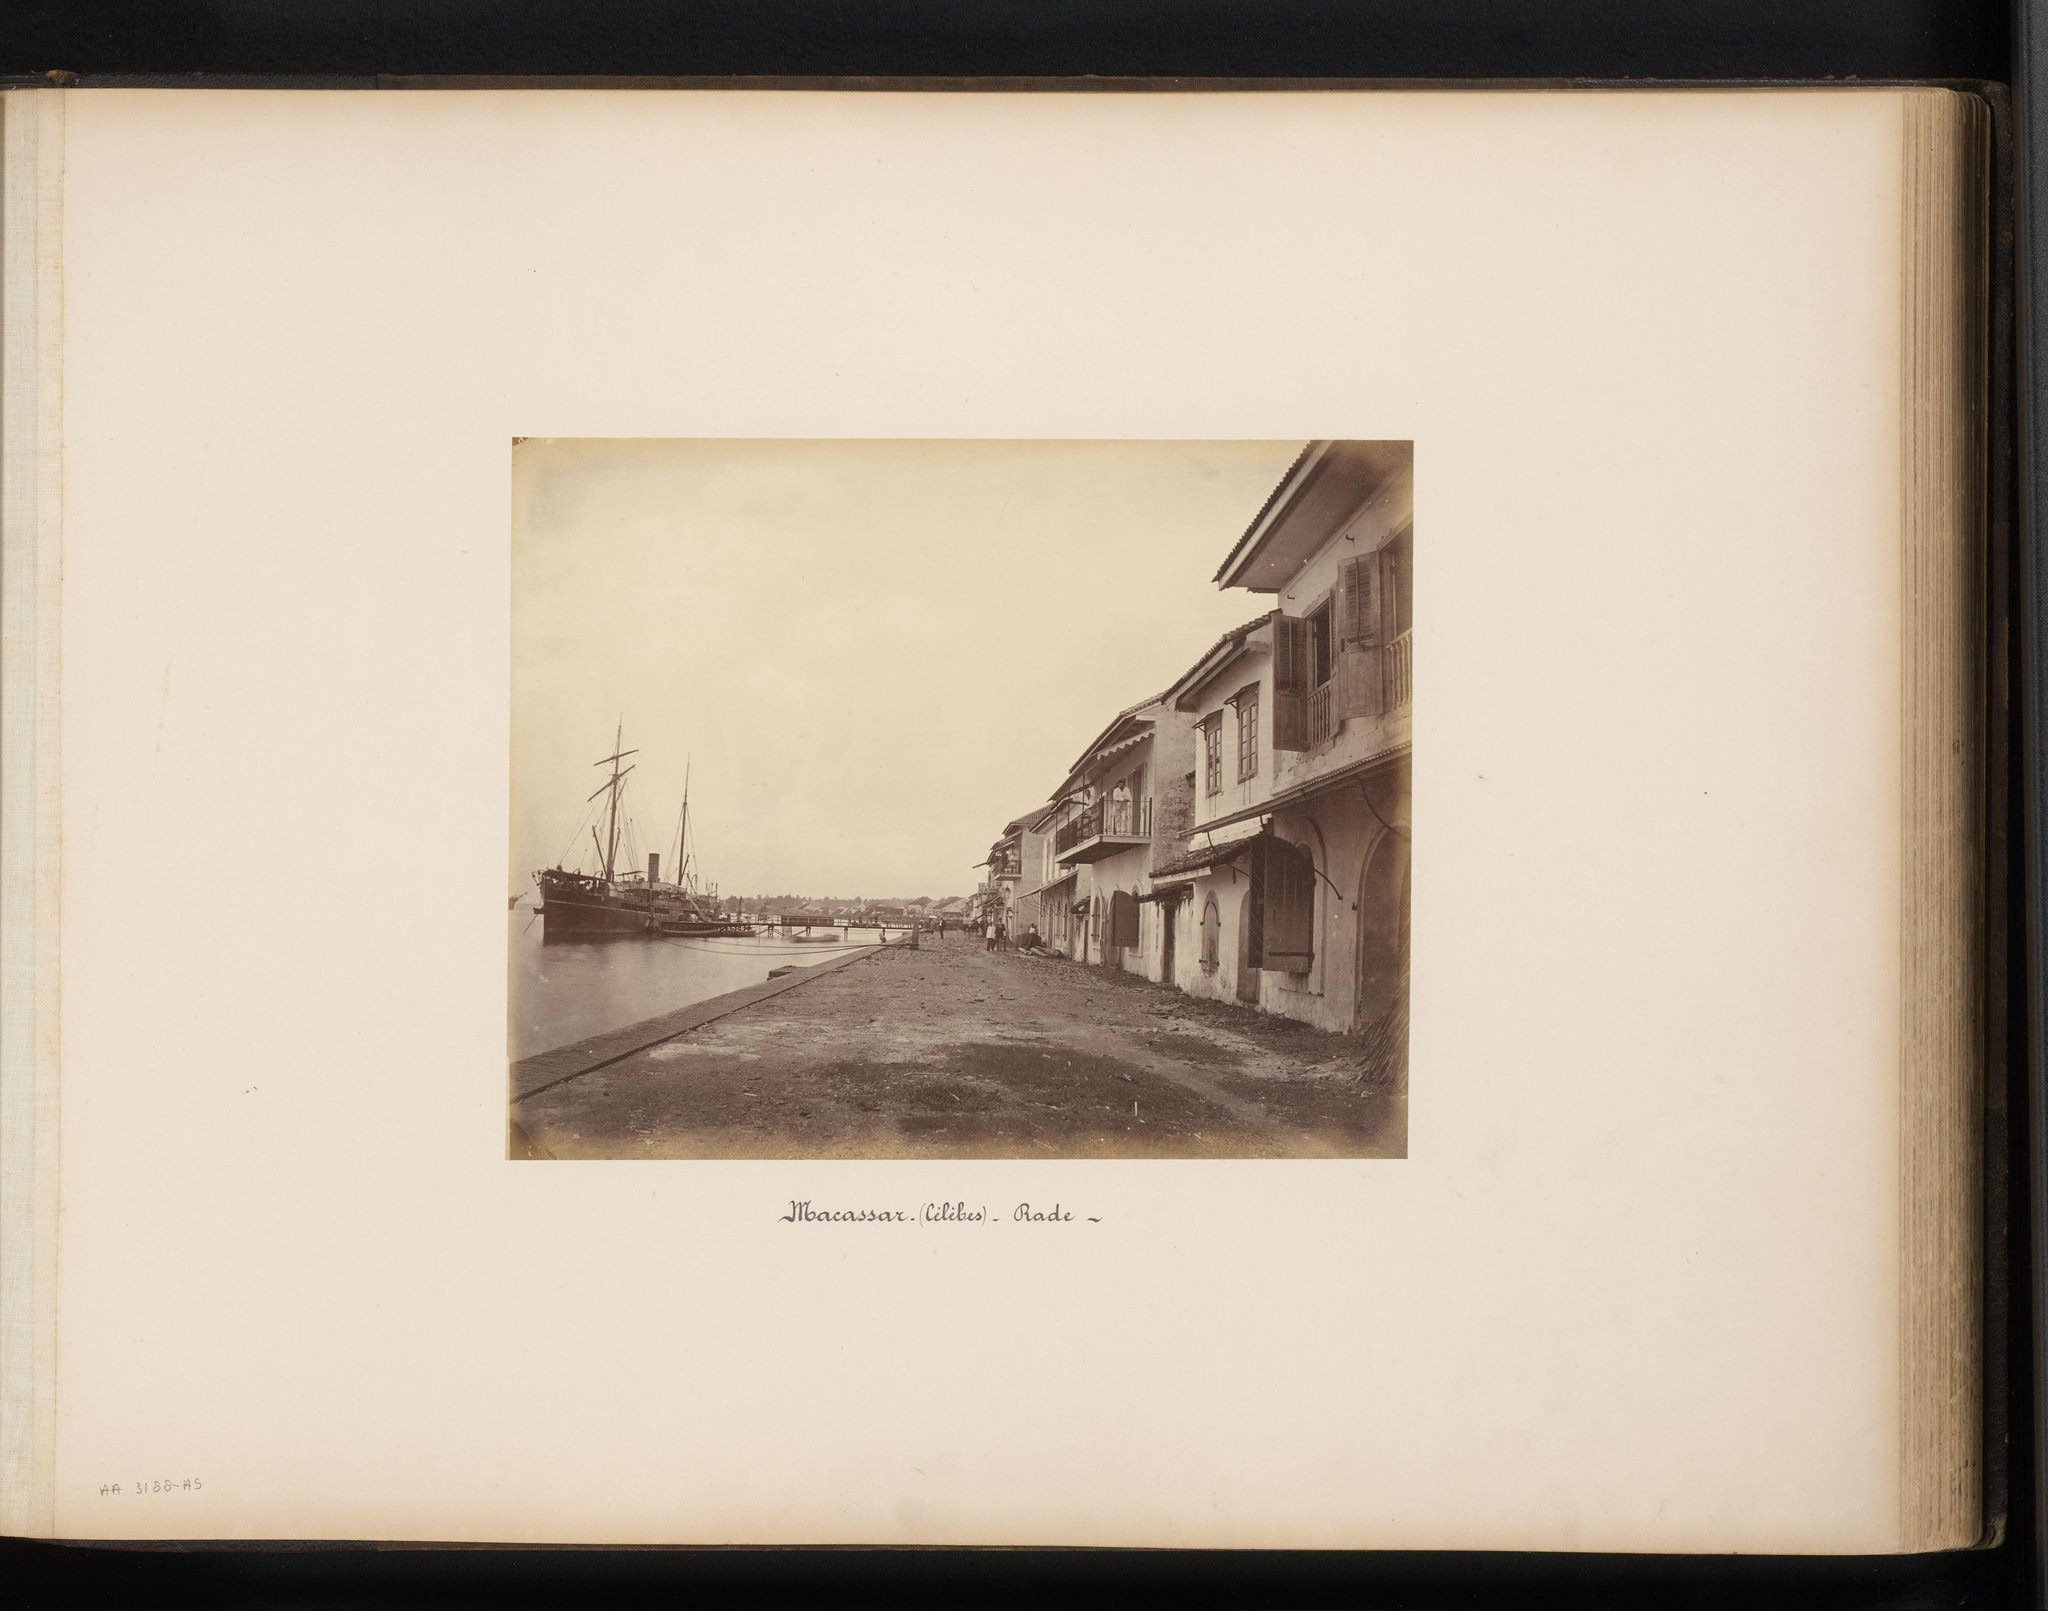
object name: photograph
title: Kade met huizen aan de haven van Makassar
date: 1880-1883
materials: photographic support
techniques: albumen print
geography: makassar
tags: harbour (+ view ~ vehicle, ship, etc.), quay (+ city(-scape) with figures, staffage)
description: Onderdeel van Reisalbum met opnames van bezienswaardigheden in Egypte, Nederlands-Indië, Singapore en Ceylon.